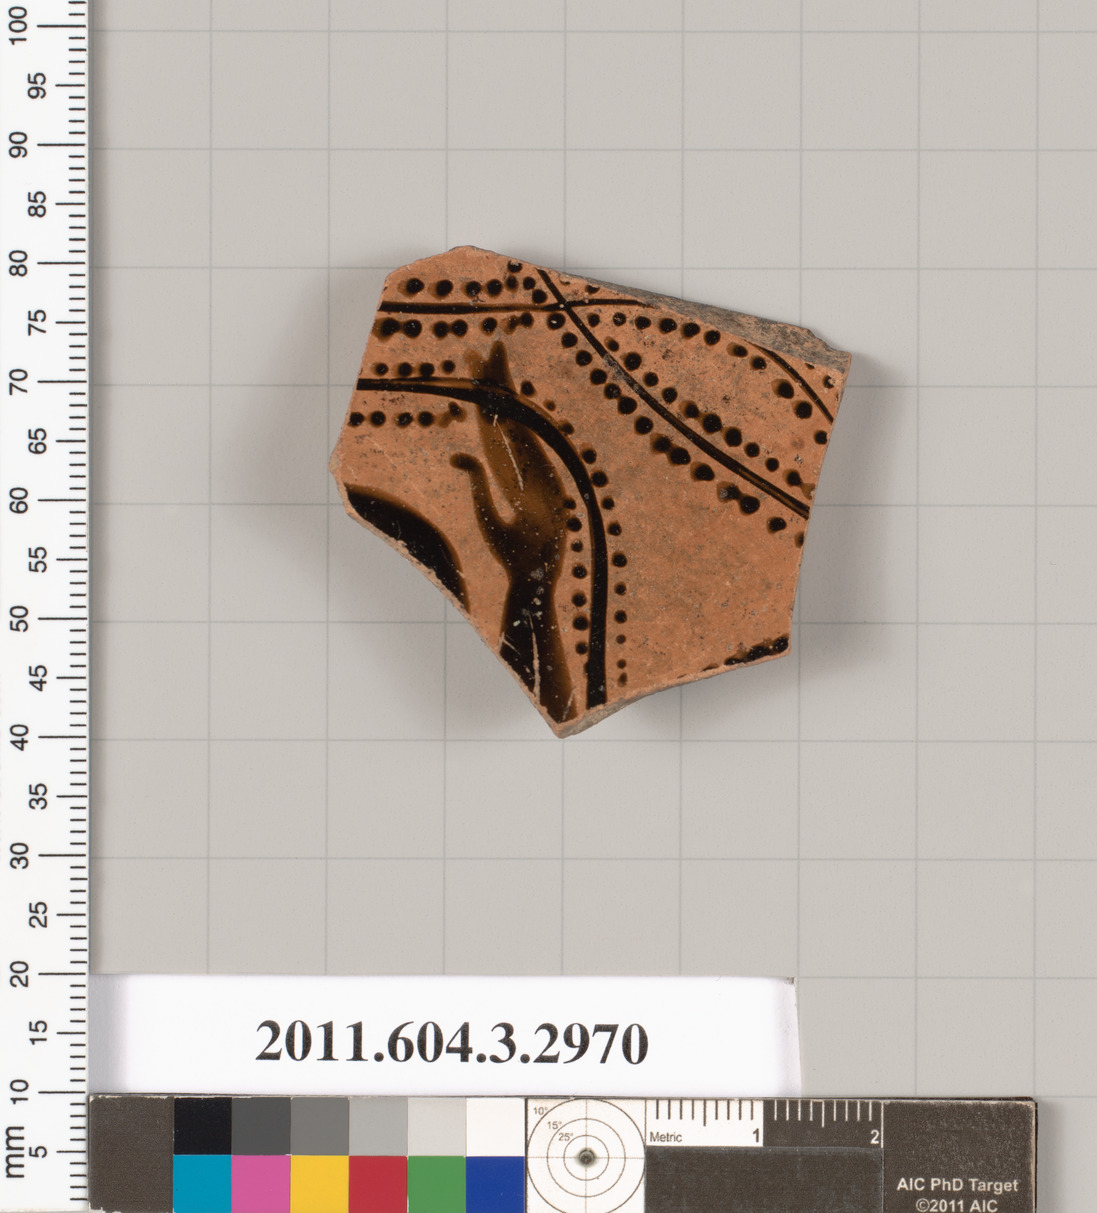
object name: plate fragment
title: Terracotta fragment of plate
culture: greek, attic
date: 534-468 BCE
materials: terracotta